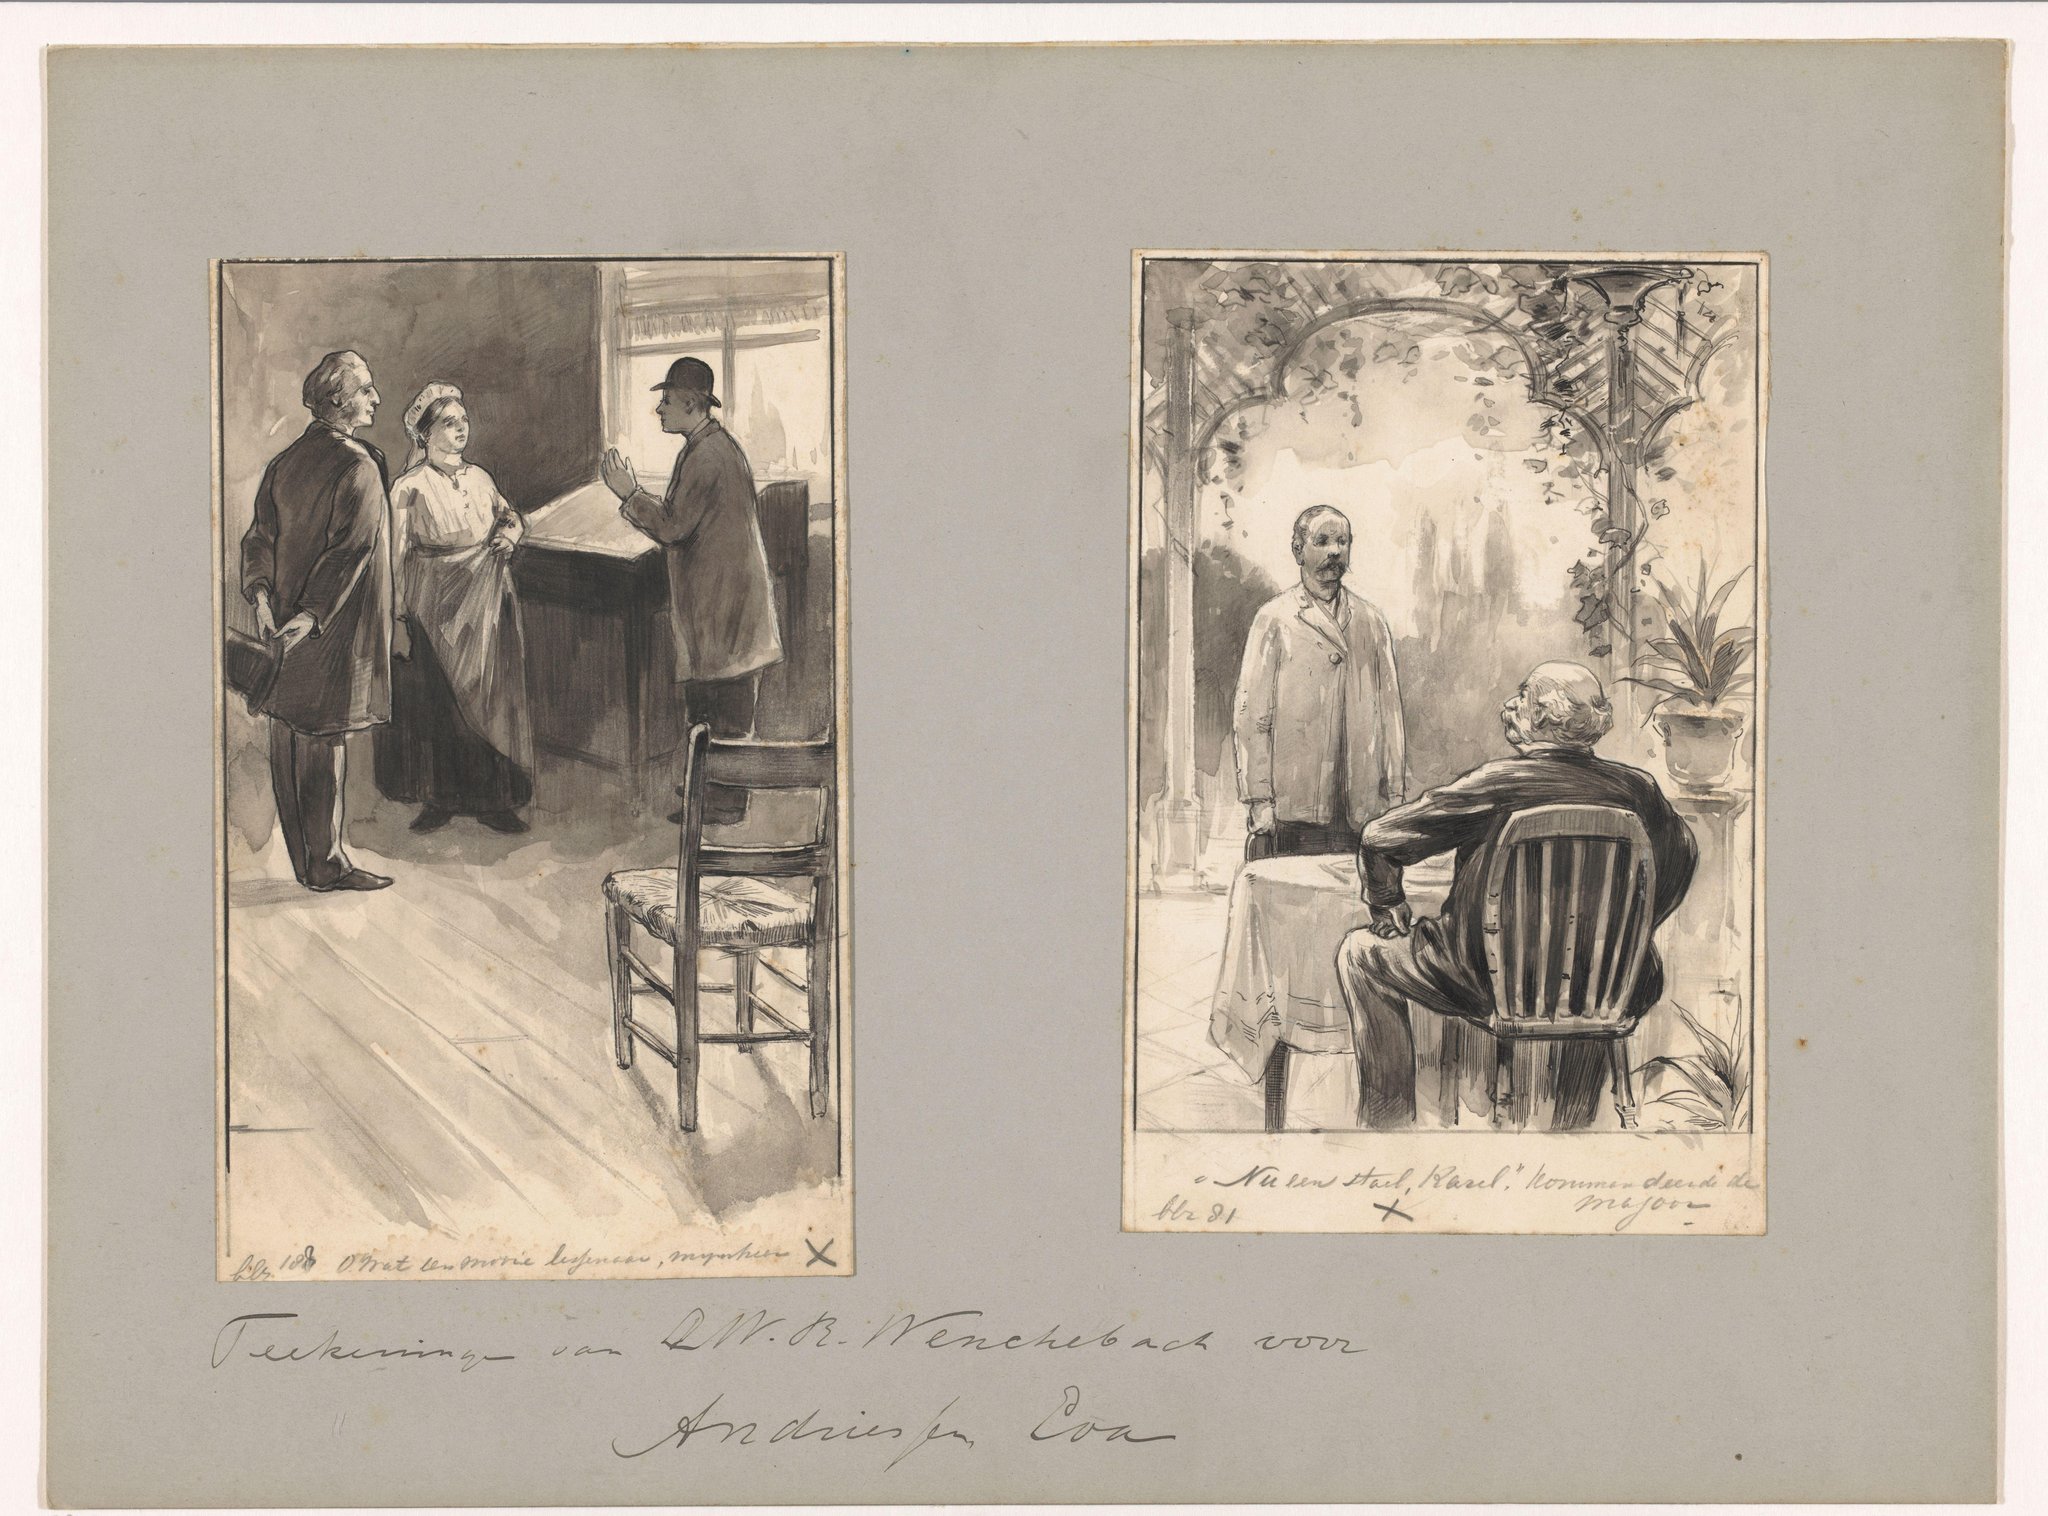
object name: drawing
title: Mannen en vrouw bij een lessenaar en man op terras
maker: willem wenckebach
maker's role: designer, draughtsman, painter, print maker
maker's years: 1860-1937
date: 1883-1904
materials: cardboard, chalk, ink, paper, pencil, watercolor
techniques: brush, pen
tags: terrace, conversation, dialogue; conversation piece, lectern ~ reading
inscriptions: collector's mark: Lugt 2228, annotation: ‘blz 188 O.Wat een mooie lessenaar, mijnheer/ "Nu een stoel, Karel," kommandeerde de/ majoor/ blz 81/ Teekeningen van L.W.R. Wenckebach voor/ Andriessen, Eva’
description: Twee ontwerpen voor boekillustraties. Links spreekt een man met een bolhoed in een interieur met een man en vrouw. Het gezelschap staat naast een lessenaar. Rechts zit een oudere man op een terras aan een tafel. Tegenover hem staat een man.